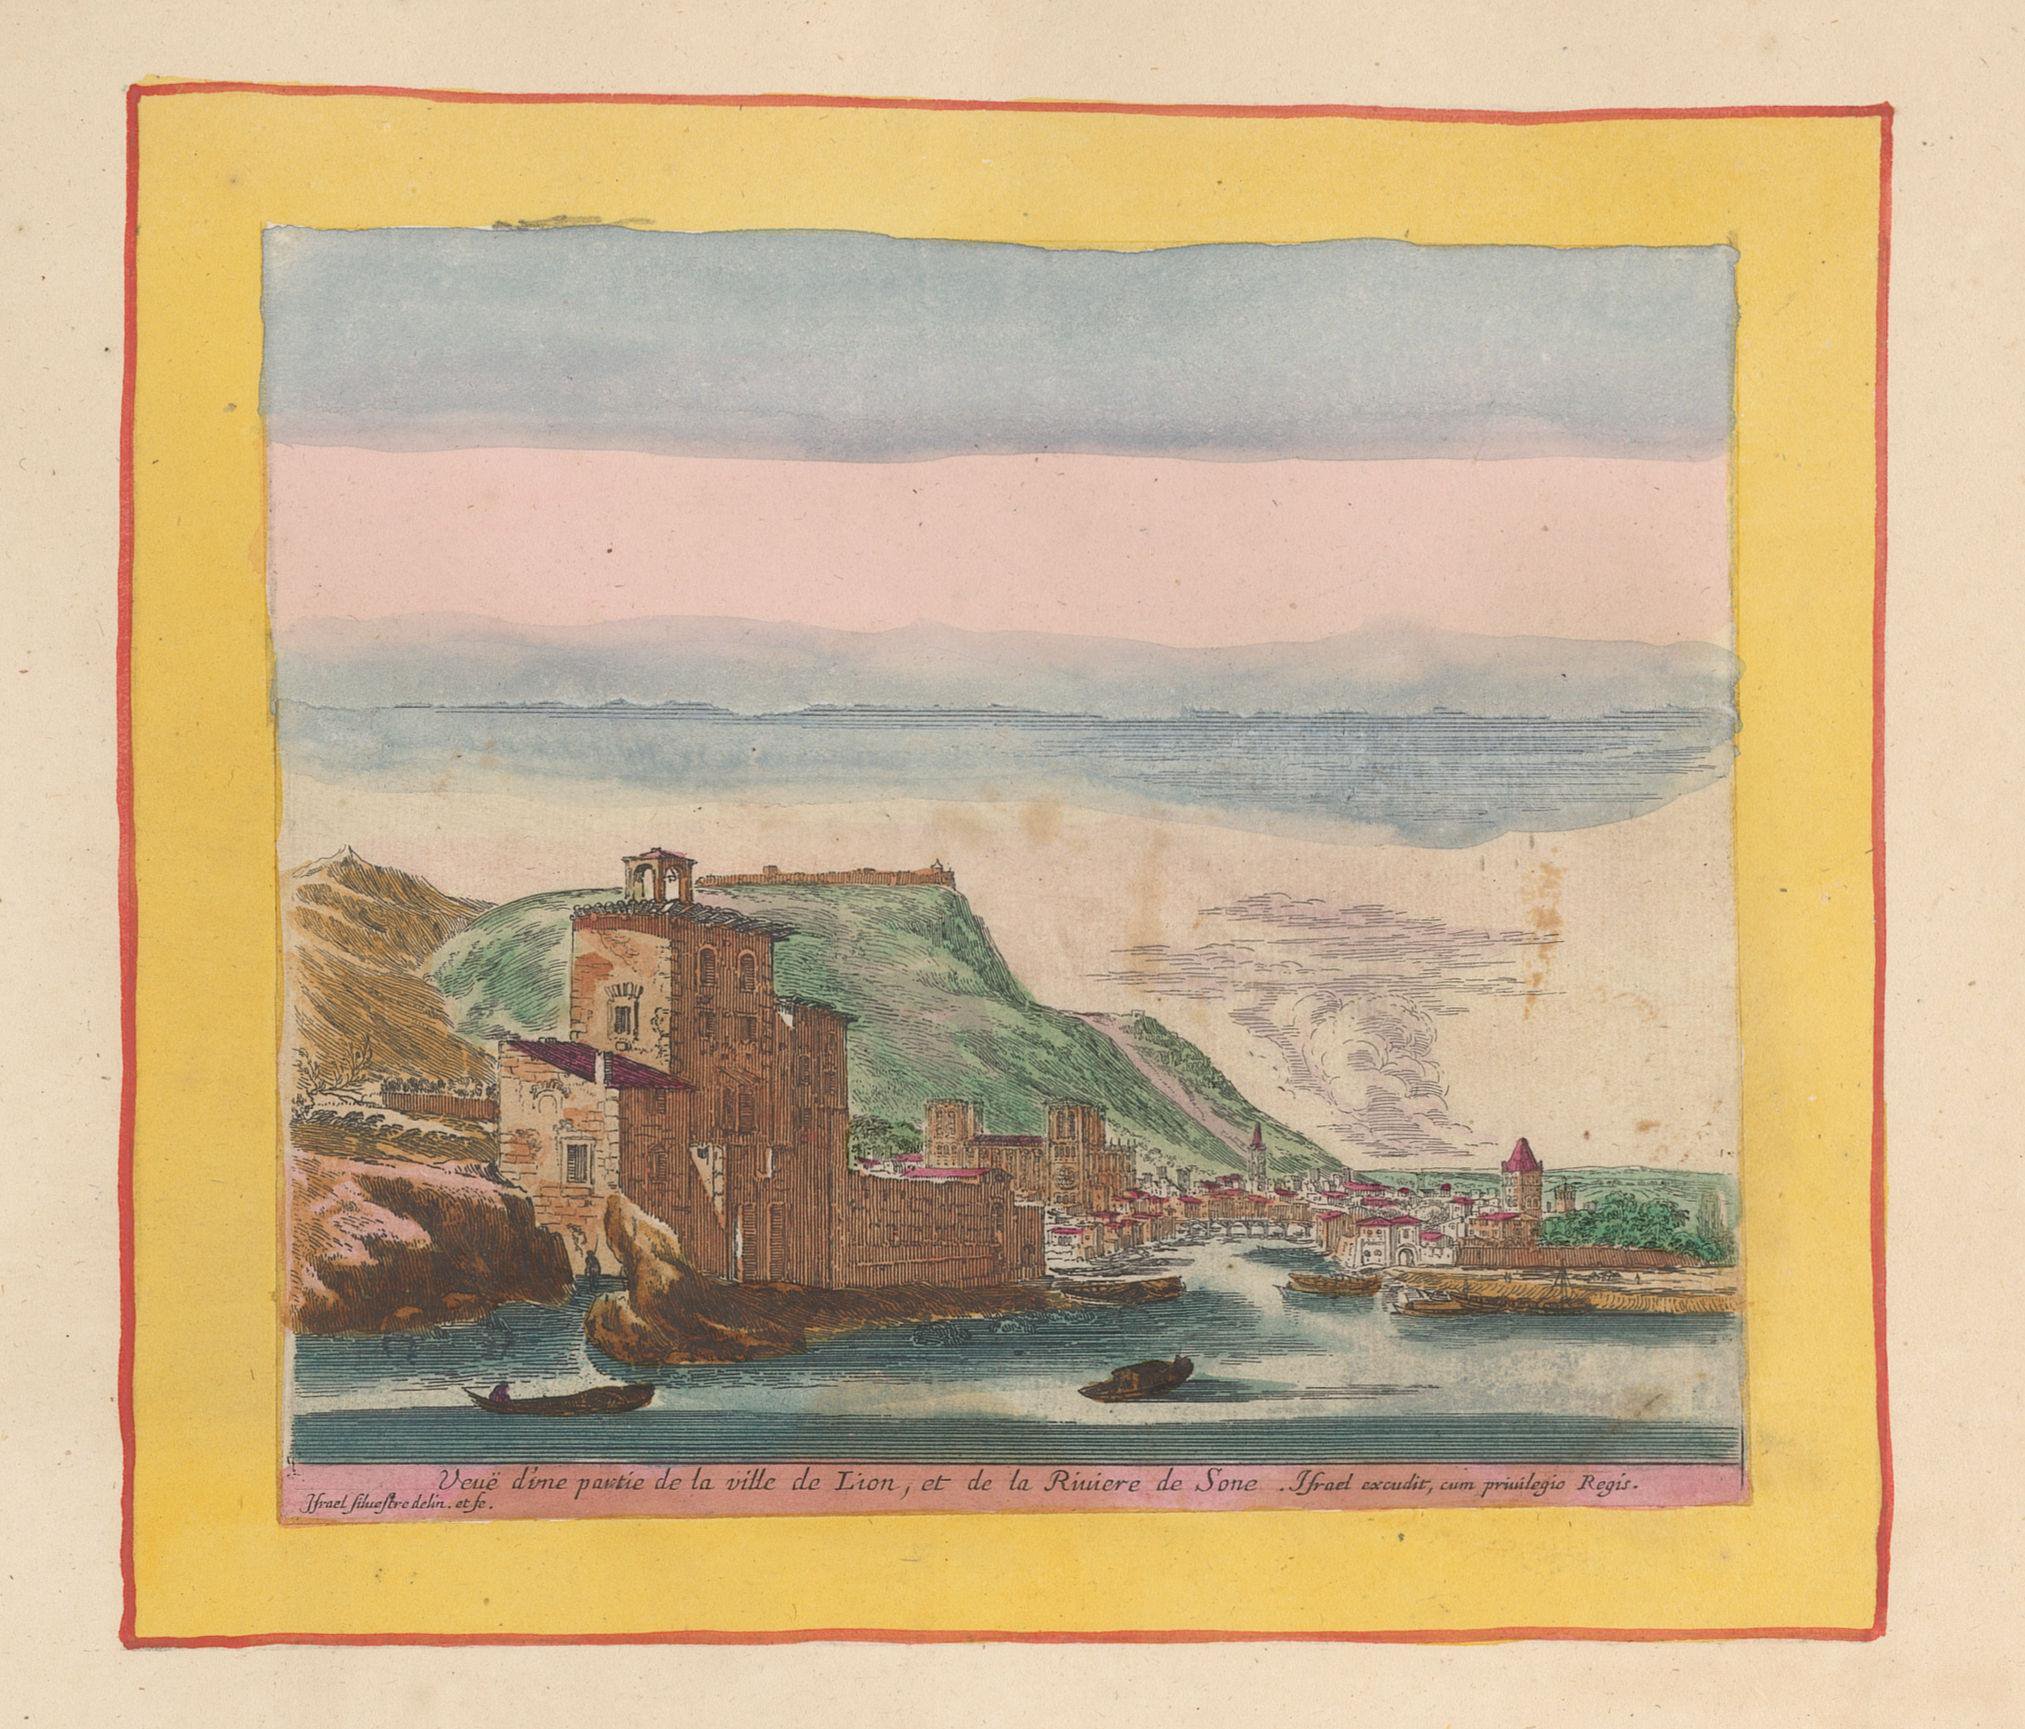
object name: print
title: Gezicht op Lyon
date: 1652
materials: paper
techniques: etching, hand coloring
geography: the hague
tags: city-view in general; 'veduta', lyon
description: Deze prent maakt deel uit van een album.